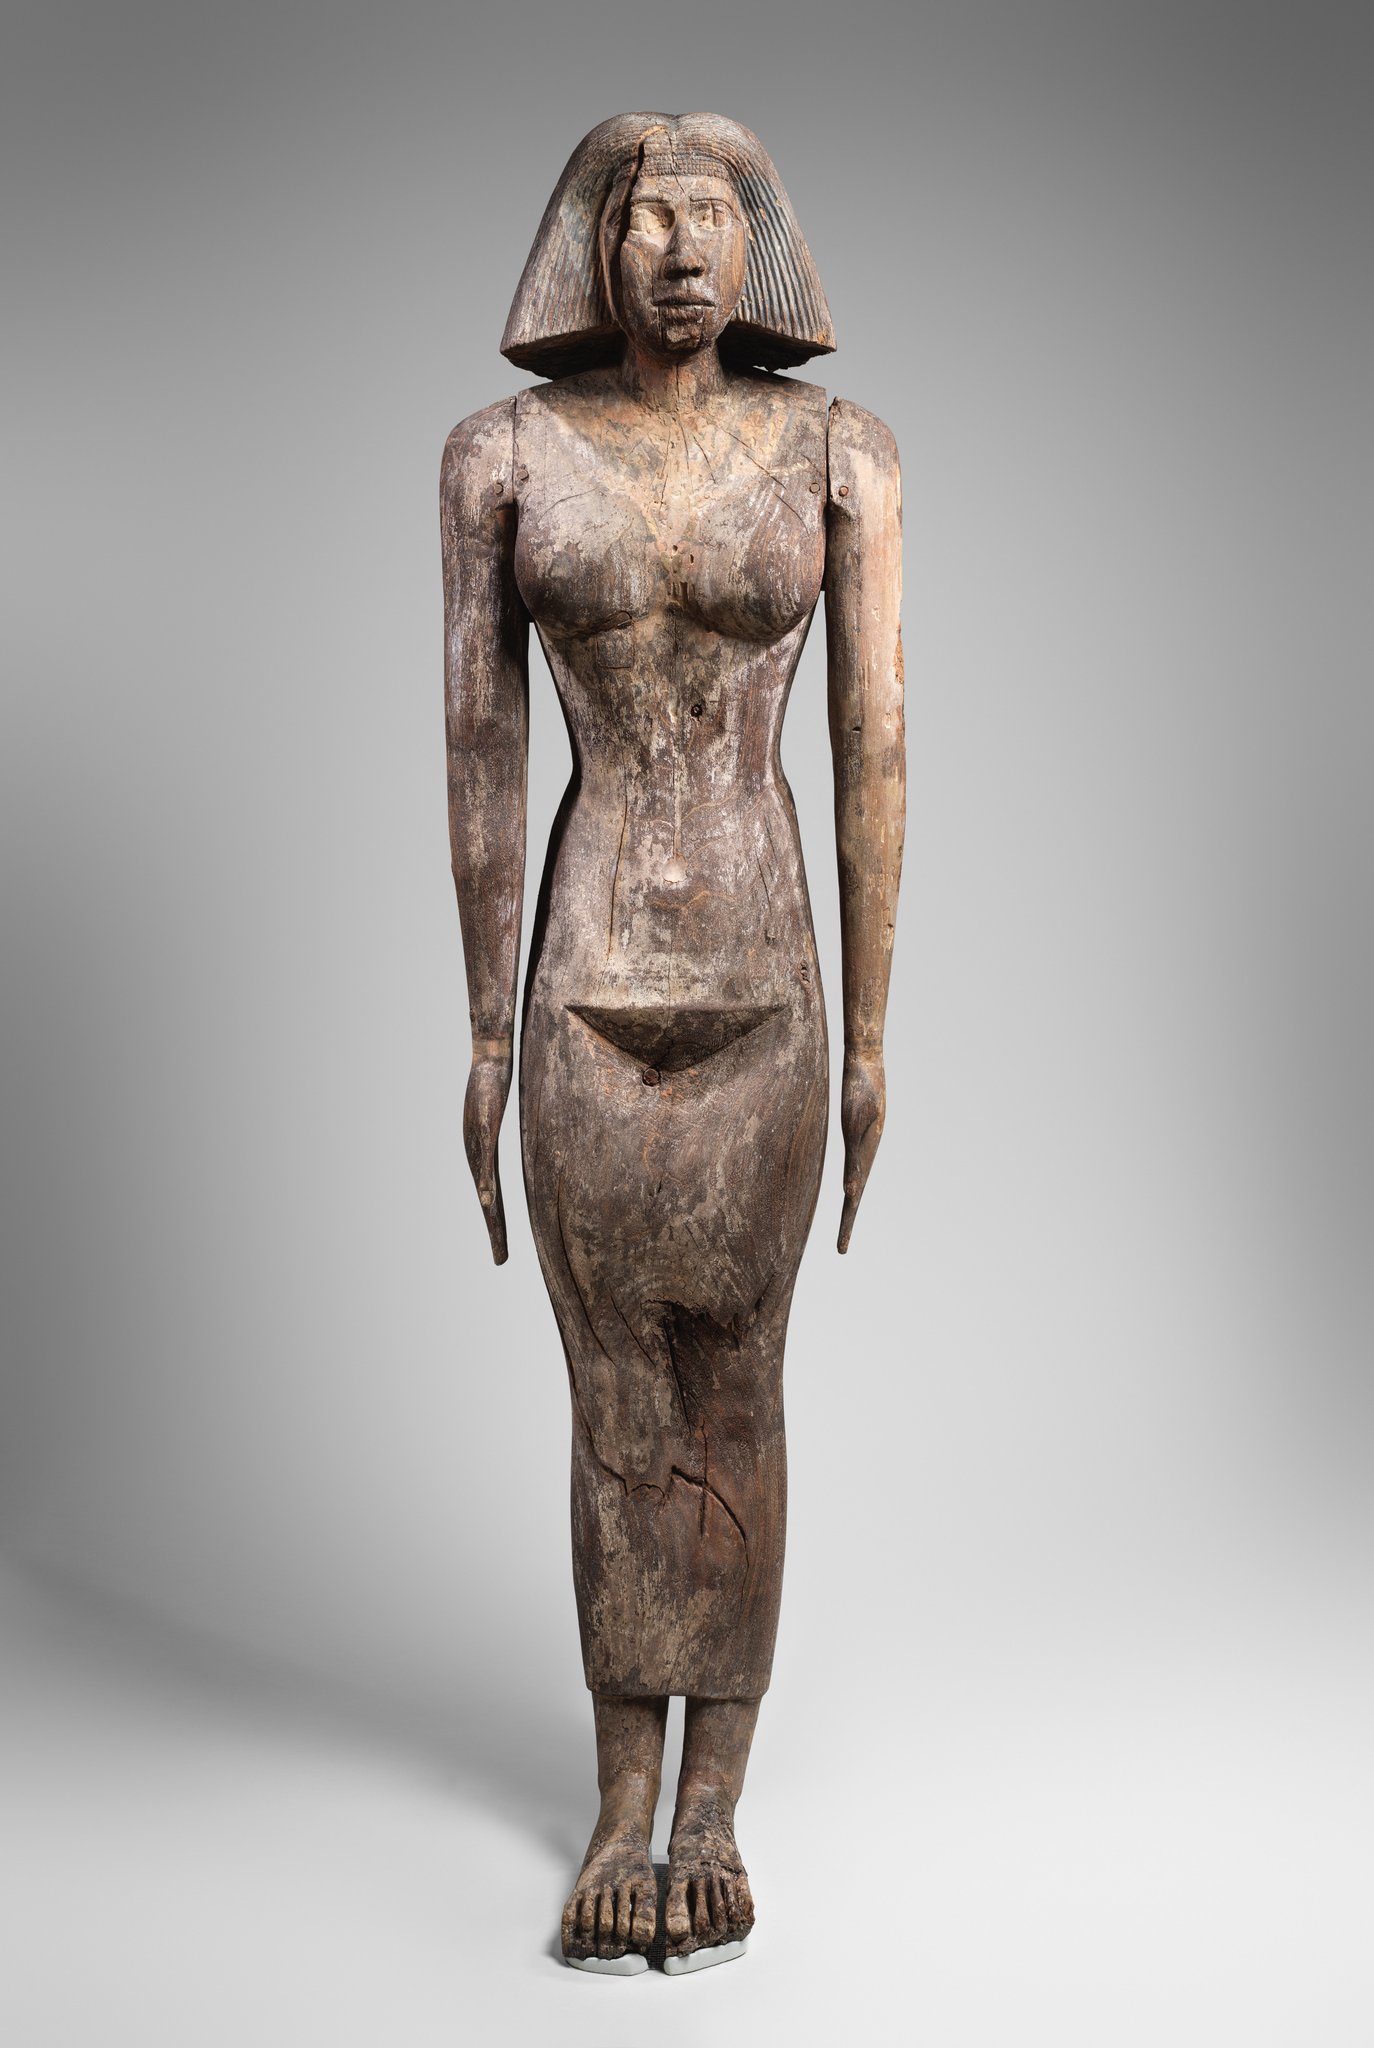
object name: statue, merti's wife, standing, mitry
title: Standing statue of Mitry's wife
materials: gesso, paint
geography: egypt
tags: women